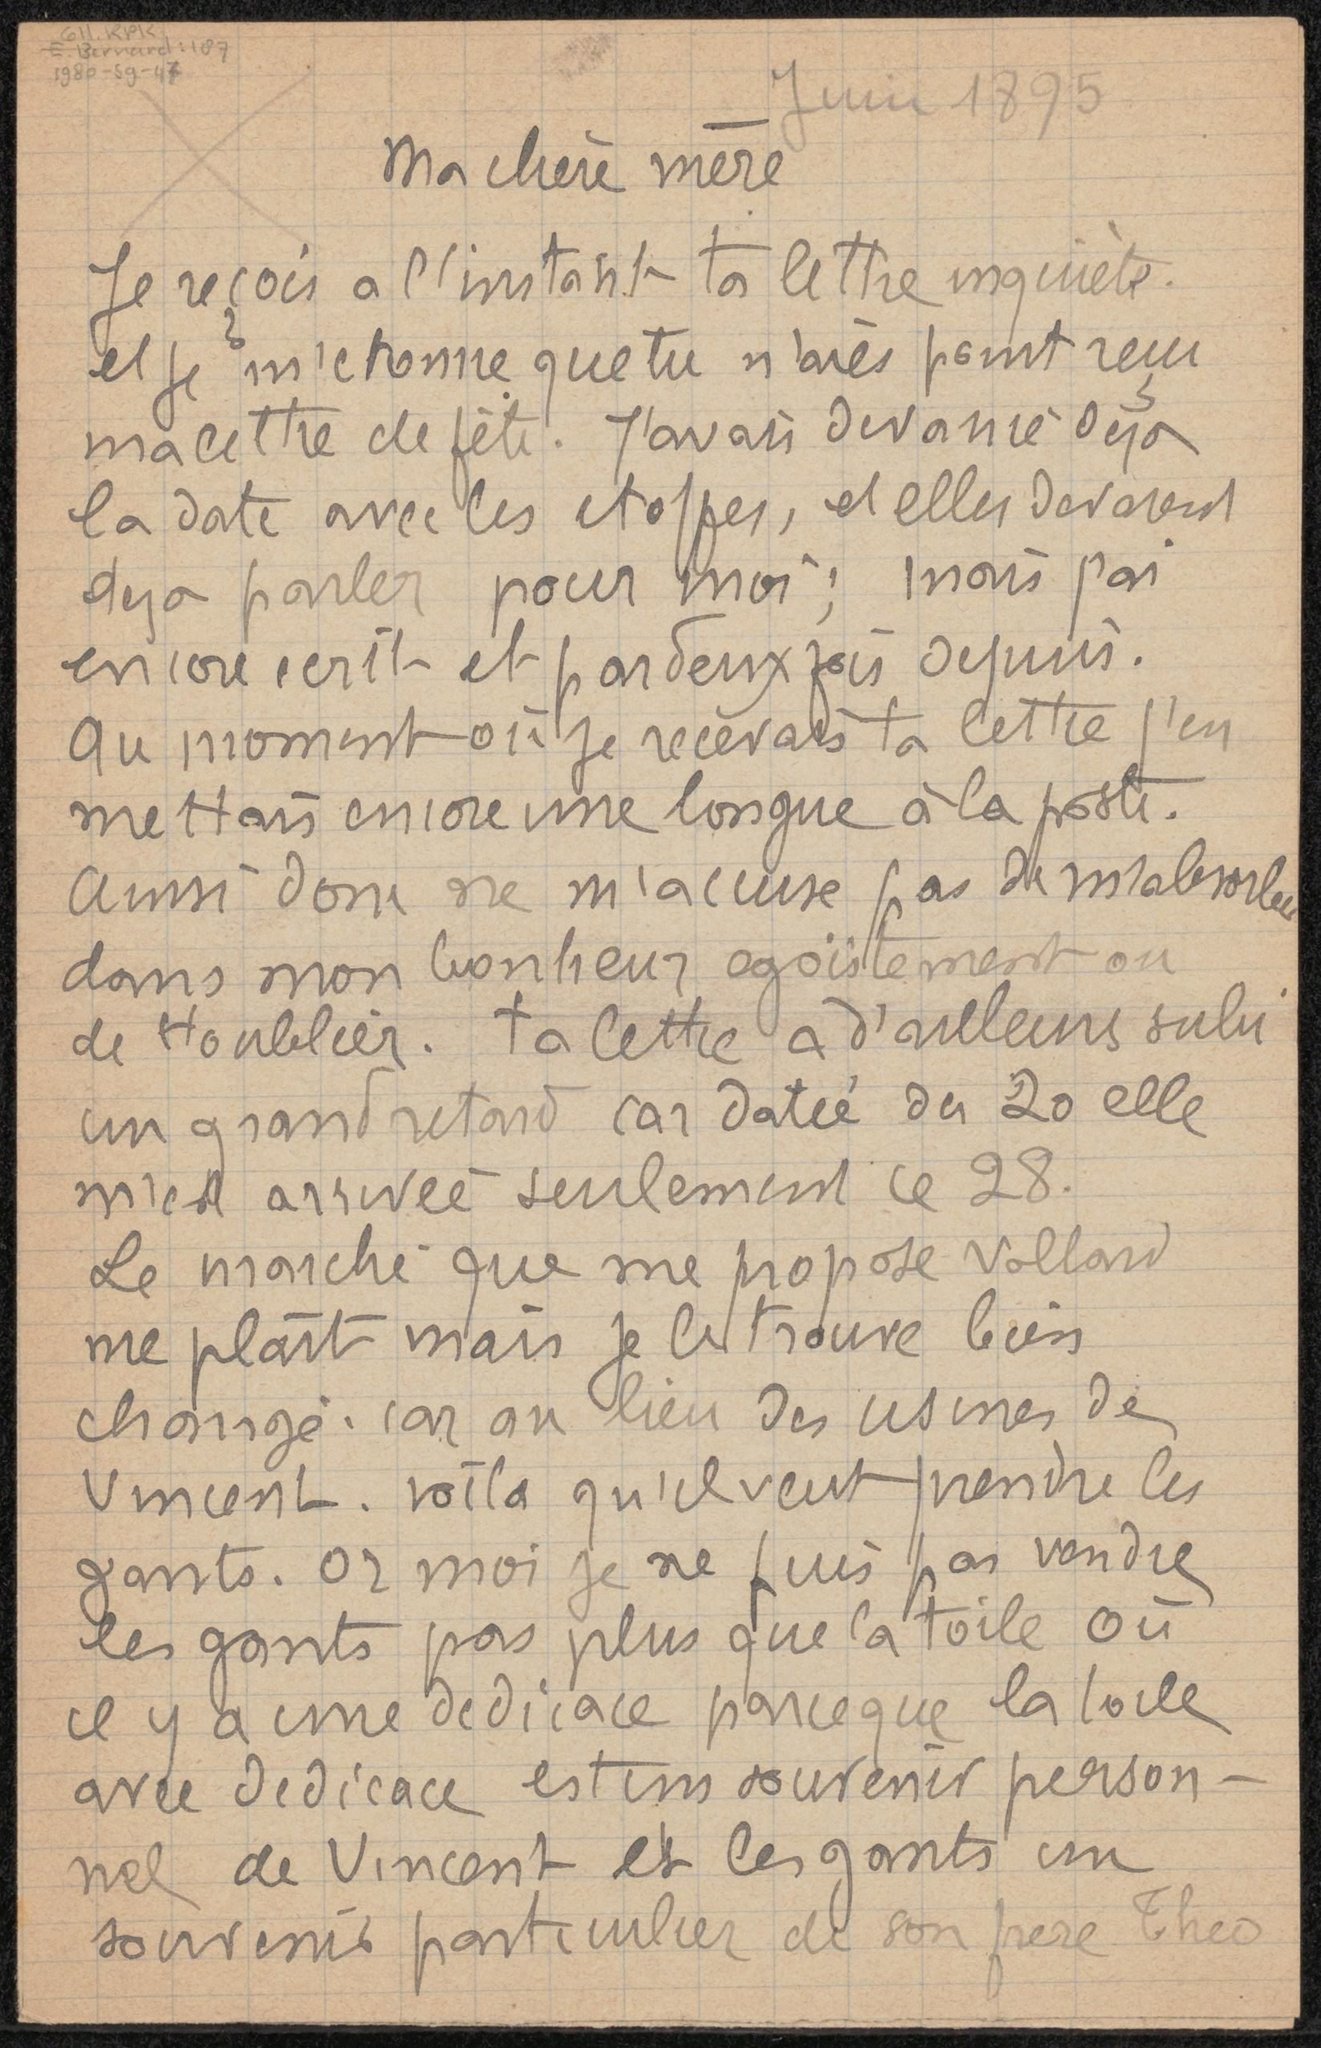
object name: letter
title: Brief aan Héloïse Bernard-Bodin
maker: émile bernard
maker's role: print maker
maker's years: 1868-1941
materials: ink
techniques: pen, writing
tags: héloïse bernard-bodin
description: Brief gedateerd Juin 1895 in latere hand.